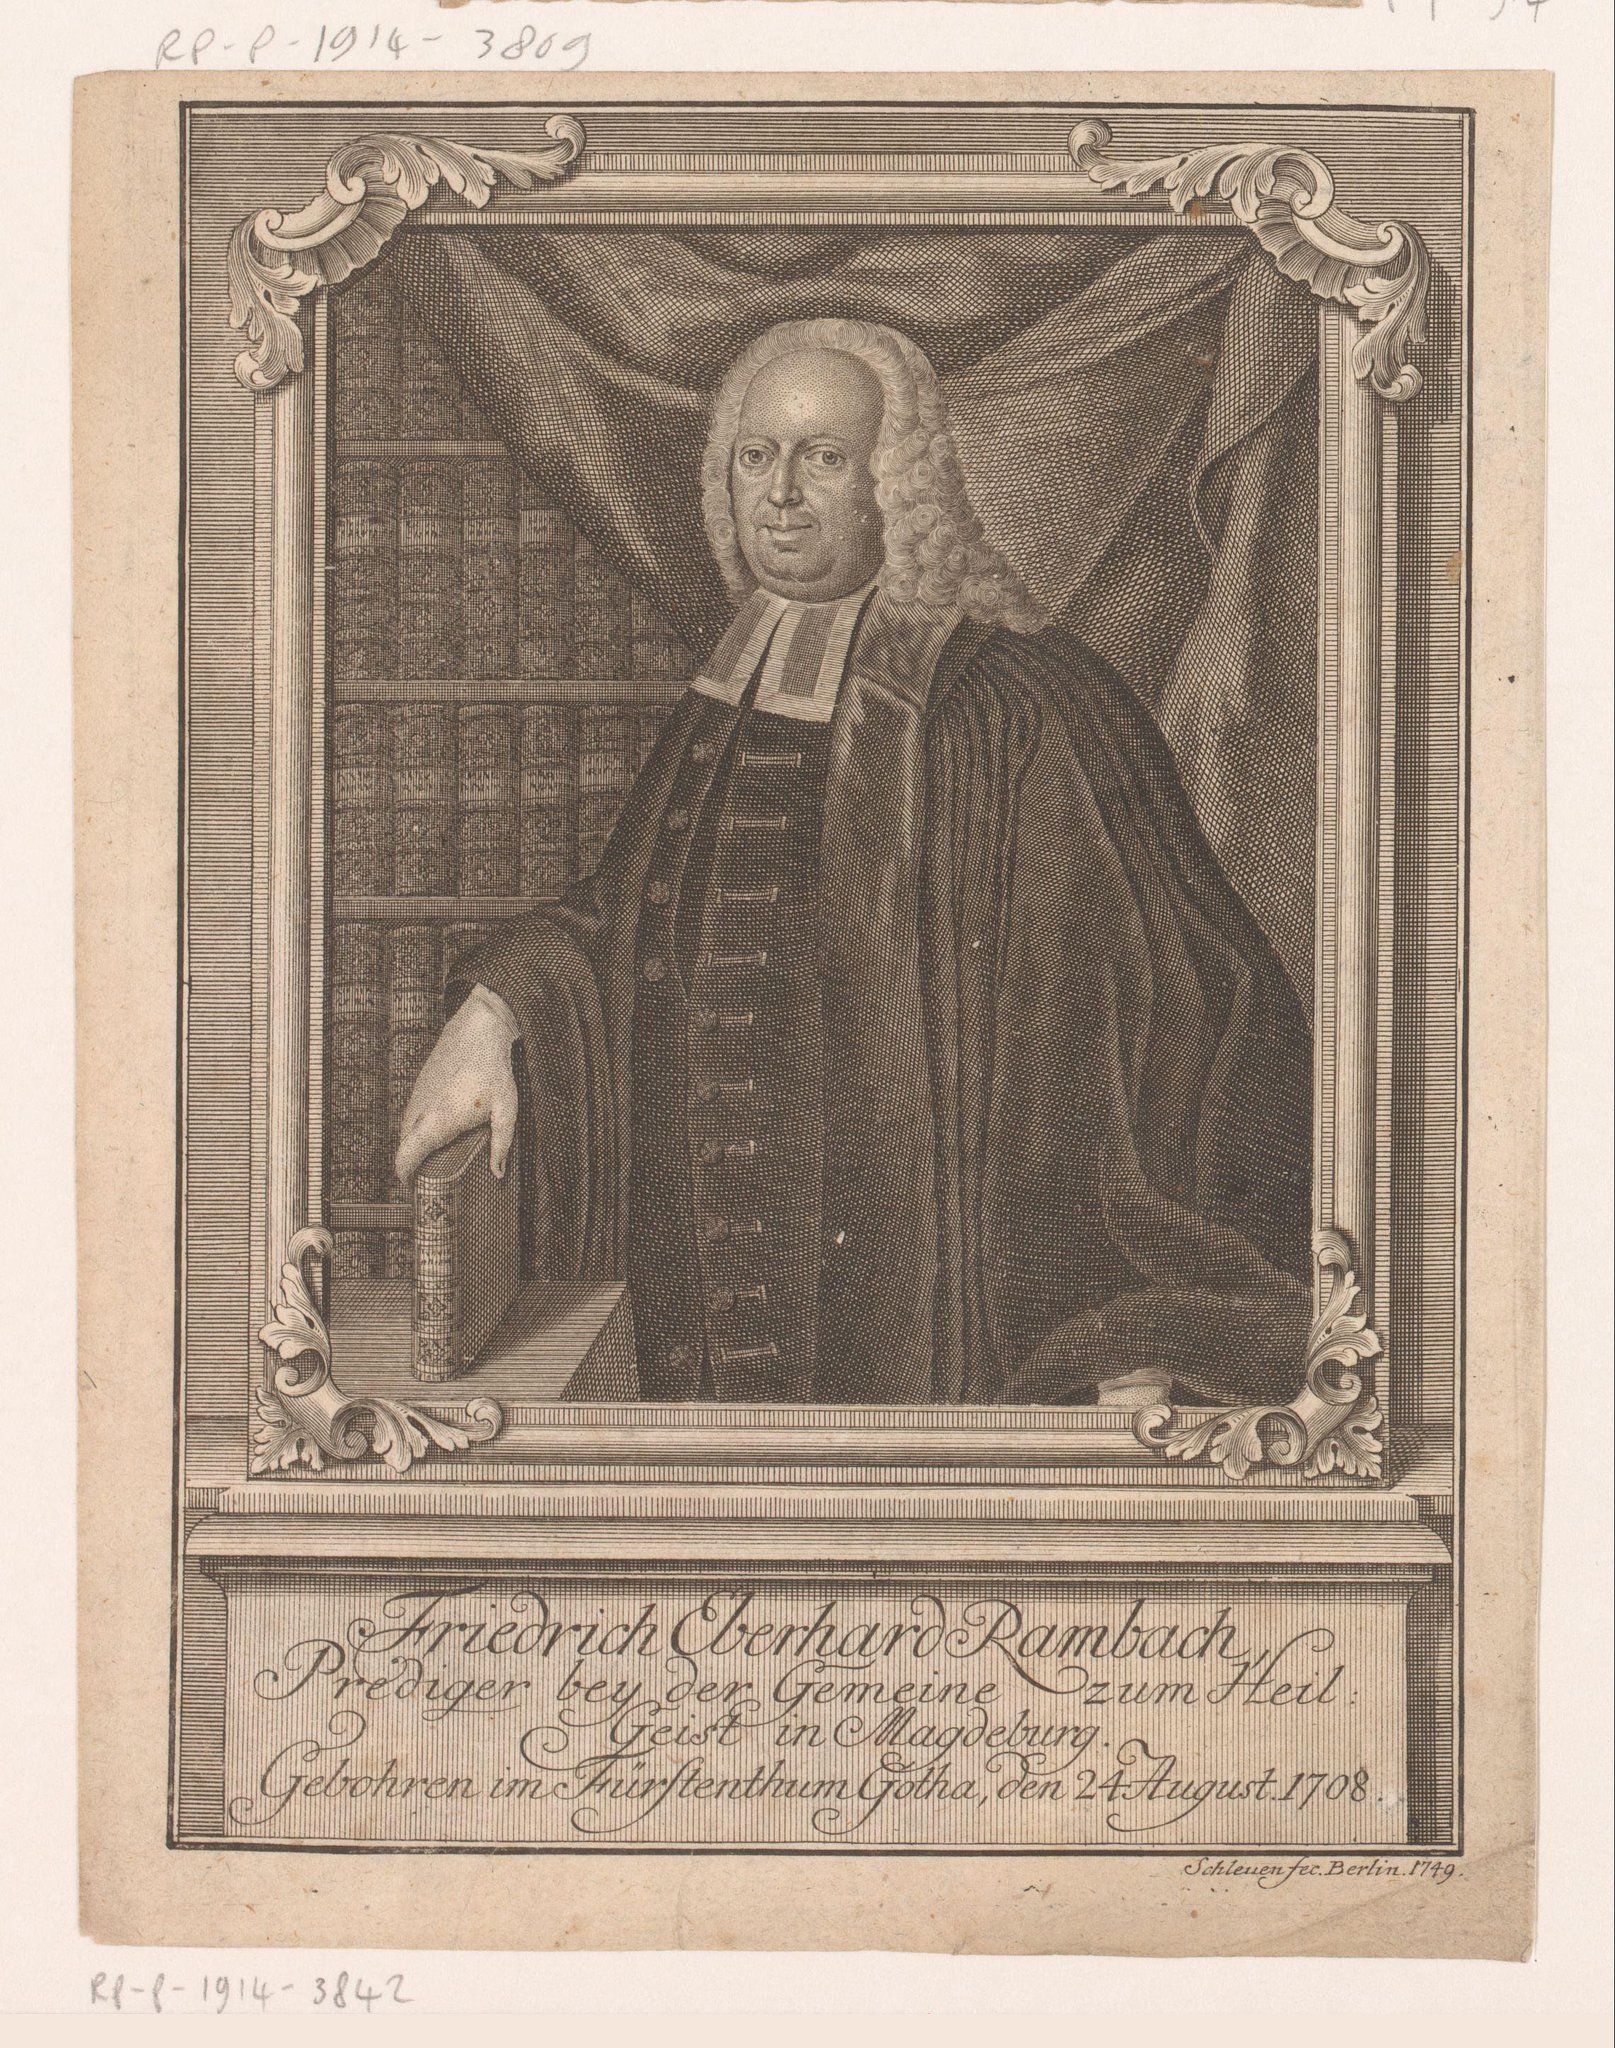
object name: print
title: Portret van Friedrich Eberhard Rambach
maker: johann david schleuen (i)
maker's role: print maker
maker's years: 1711-1774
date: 1749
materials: paper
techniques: engraving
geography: berlin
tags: historical persons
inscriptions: collector's mark: Lugt 2228